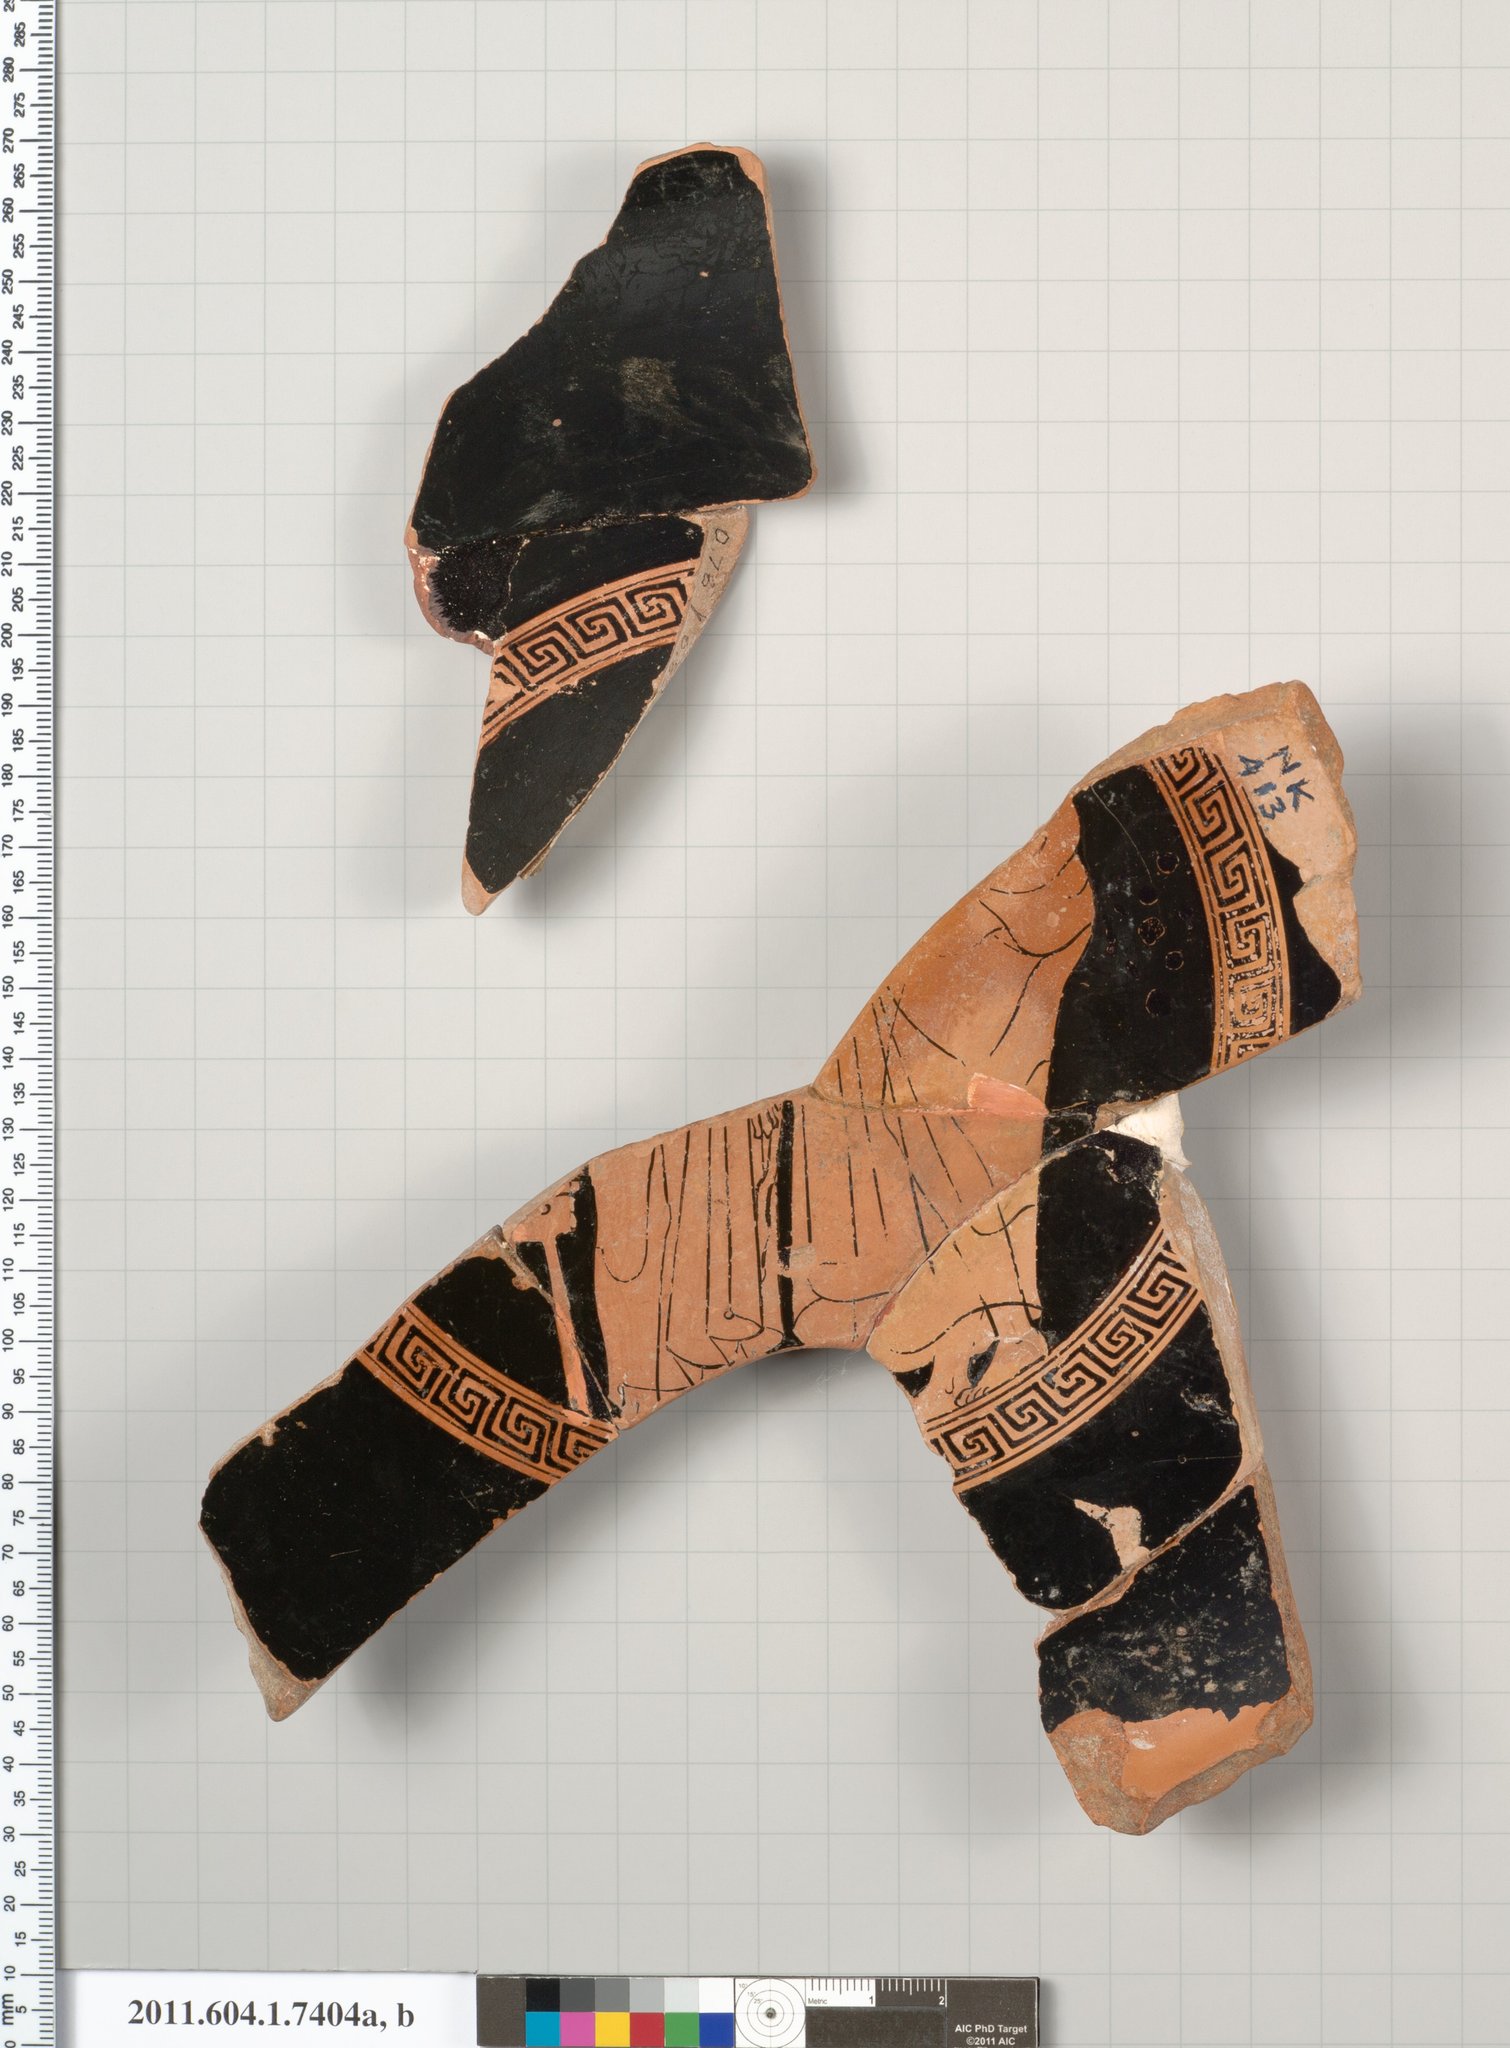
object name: kylix fragment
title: Terracotta fragments of a kylix (drinking cup)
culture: greek, attic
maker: makron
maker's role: artist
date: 500-480 BCE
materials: terracotta